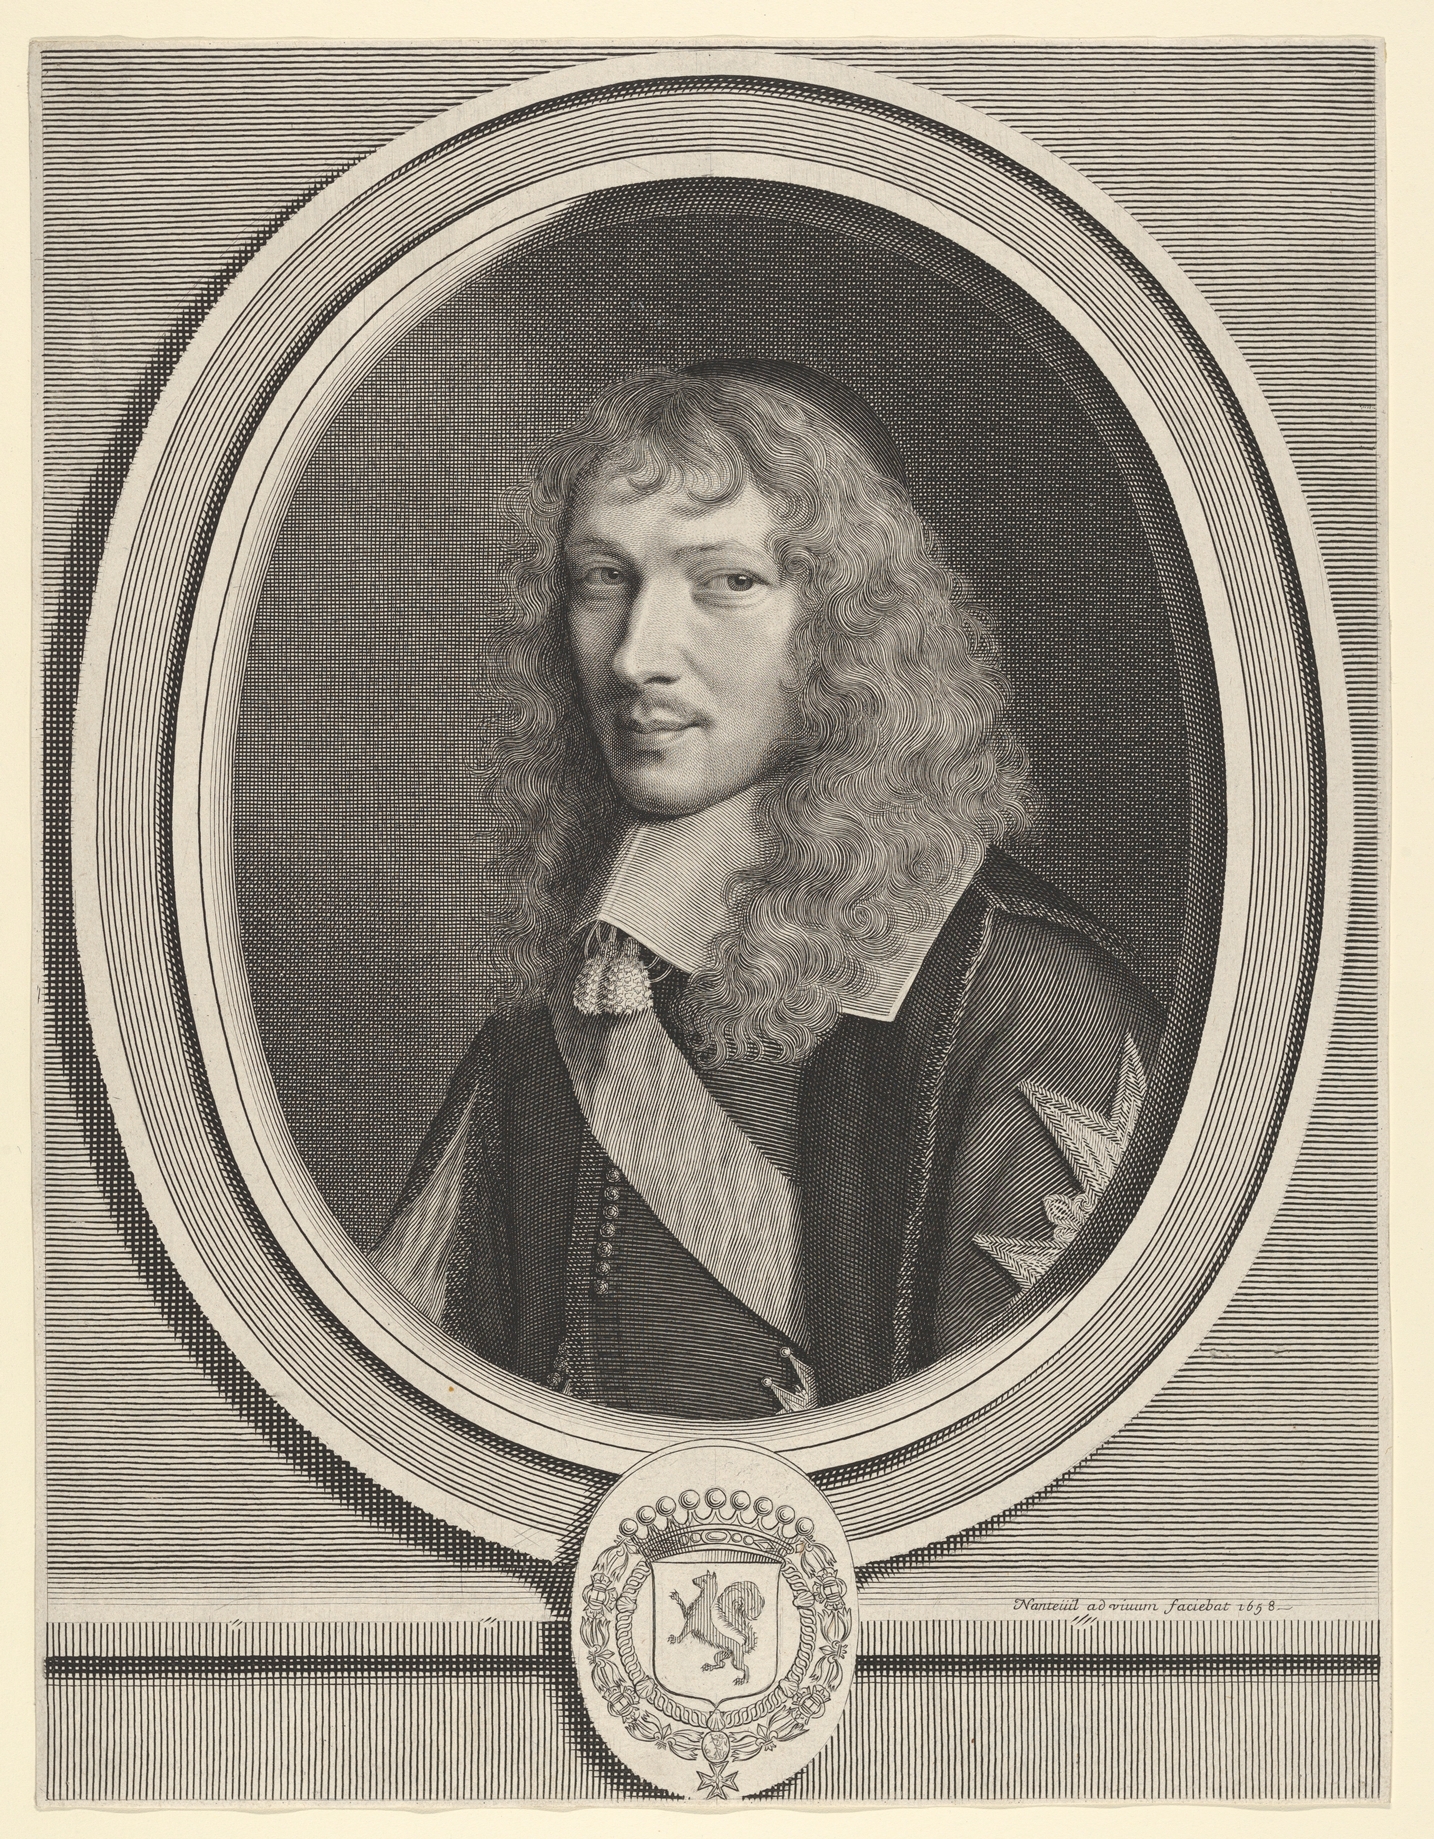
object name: print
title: Basile Fouquet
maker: robert nanteuil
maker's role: artist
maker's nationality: french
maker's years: 1623-1678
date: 1658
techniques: engraving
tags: men,portraits,coat of arms